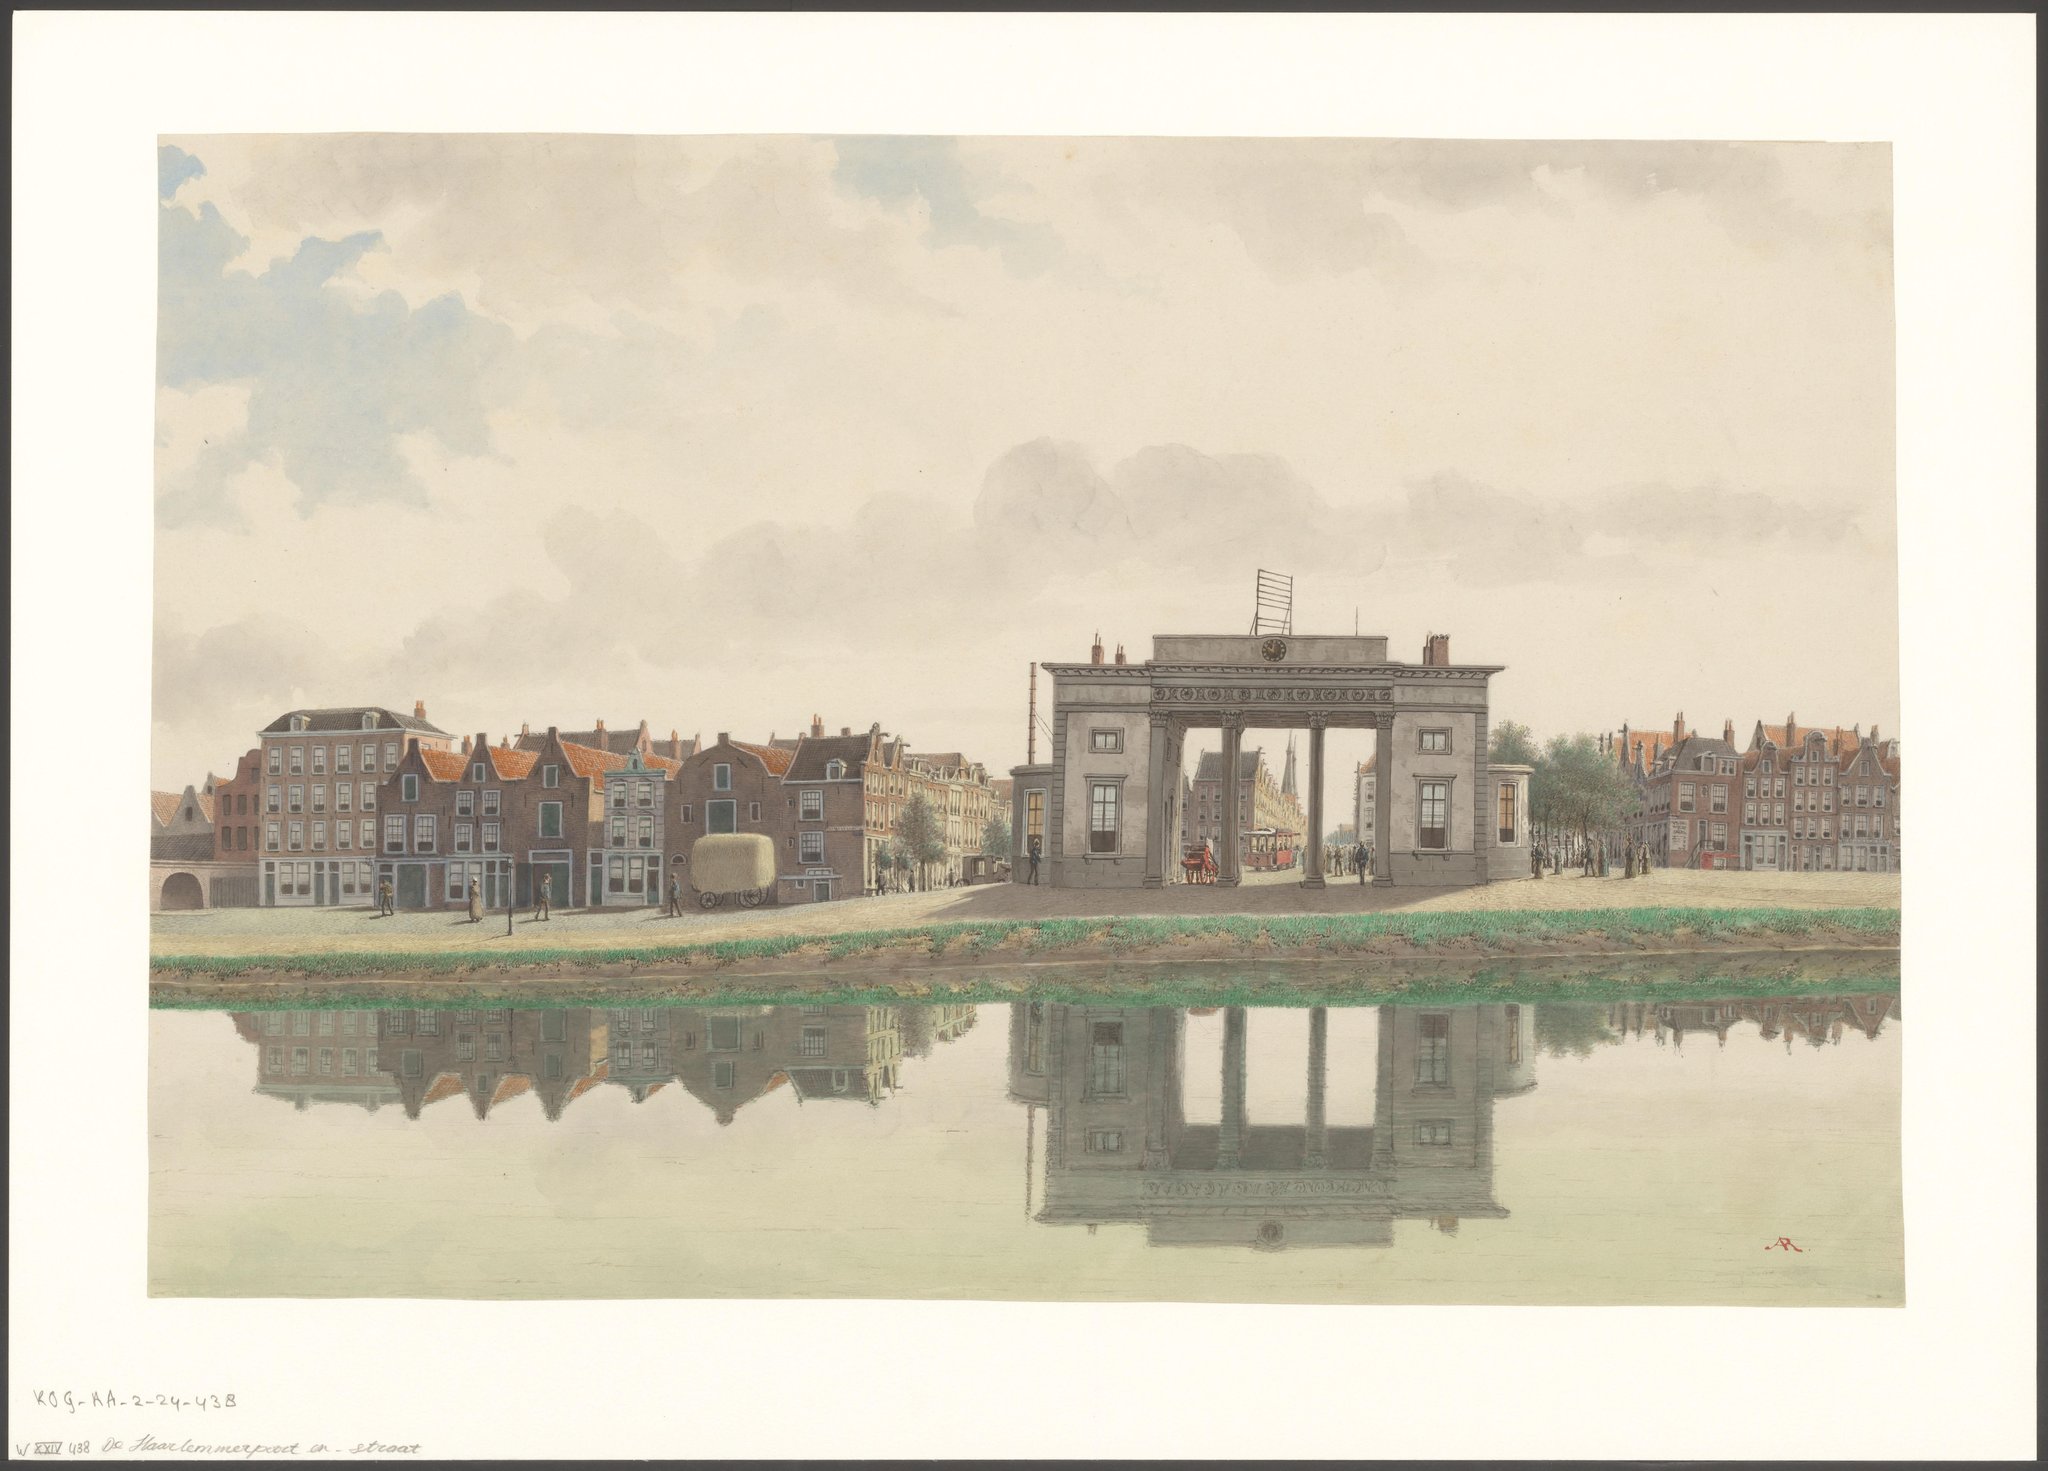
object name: drawing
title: Gezicht op de Willemspoort vanaf de Nassaukade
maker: johan martinus anthon rieke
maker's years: 1851-1899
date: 1891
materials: ink, paper, pencil, watercolor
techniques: brush, pen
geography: amsterdam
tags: city-view in general; 'veduta', canal, city-gate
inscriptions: inscription: ‘ziende op de Haarlemmerpoort van af de Nassaukade / te / Amsterdam / J.M.A. Rieke fecit 1891’, signature: ‘JMAR.’, collector's mark: Lugt 800a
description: Tekening binnen de Atlas Van Eck ingedeeld op wijknummer 24.